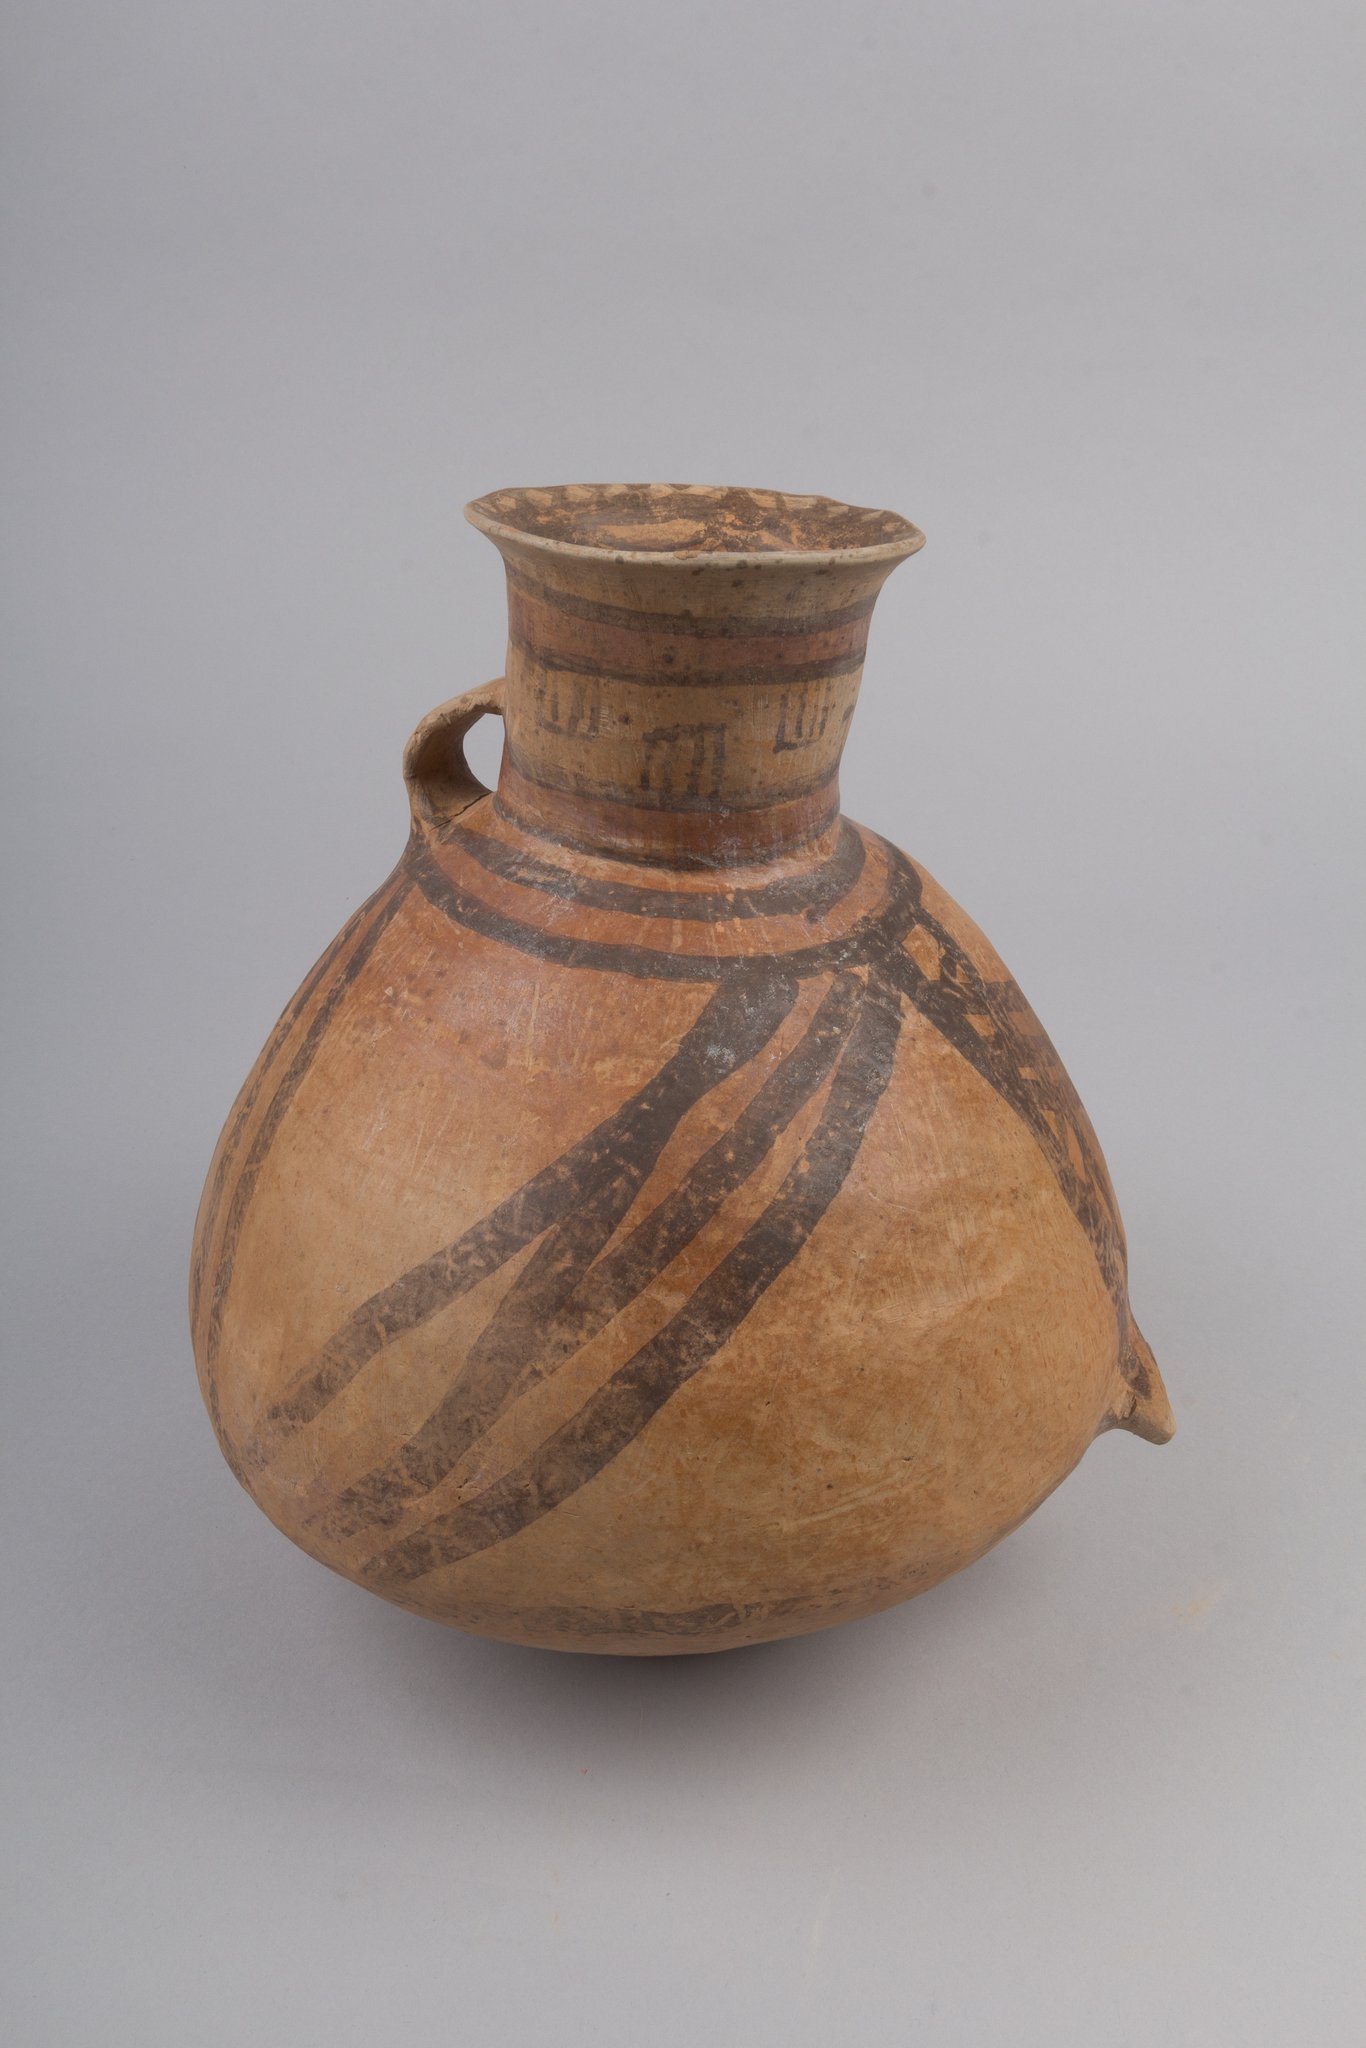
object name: jar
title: Jar with Two Loop Handles (Hu)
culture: chinese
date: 2300-2000 BCE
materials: earthenware, pigment